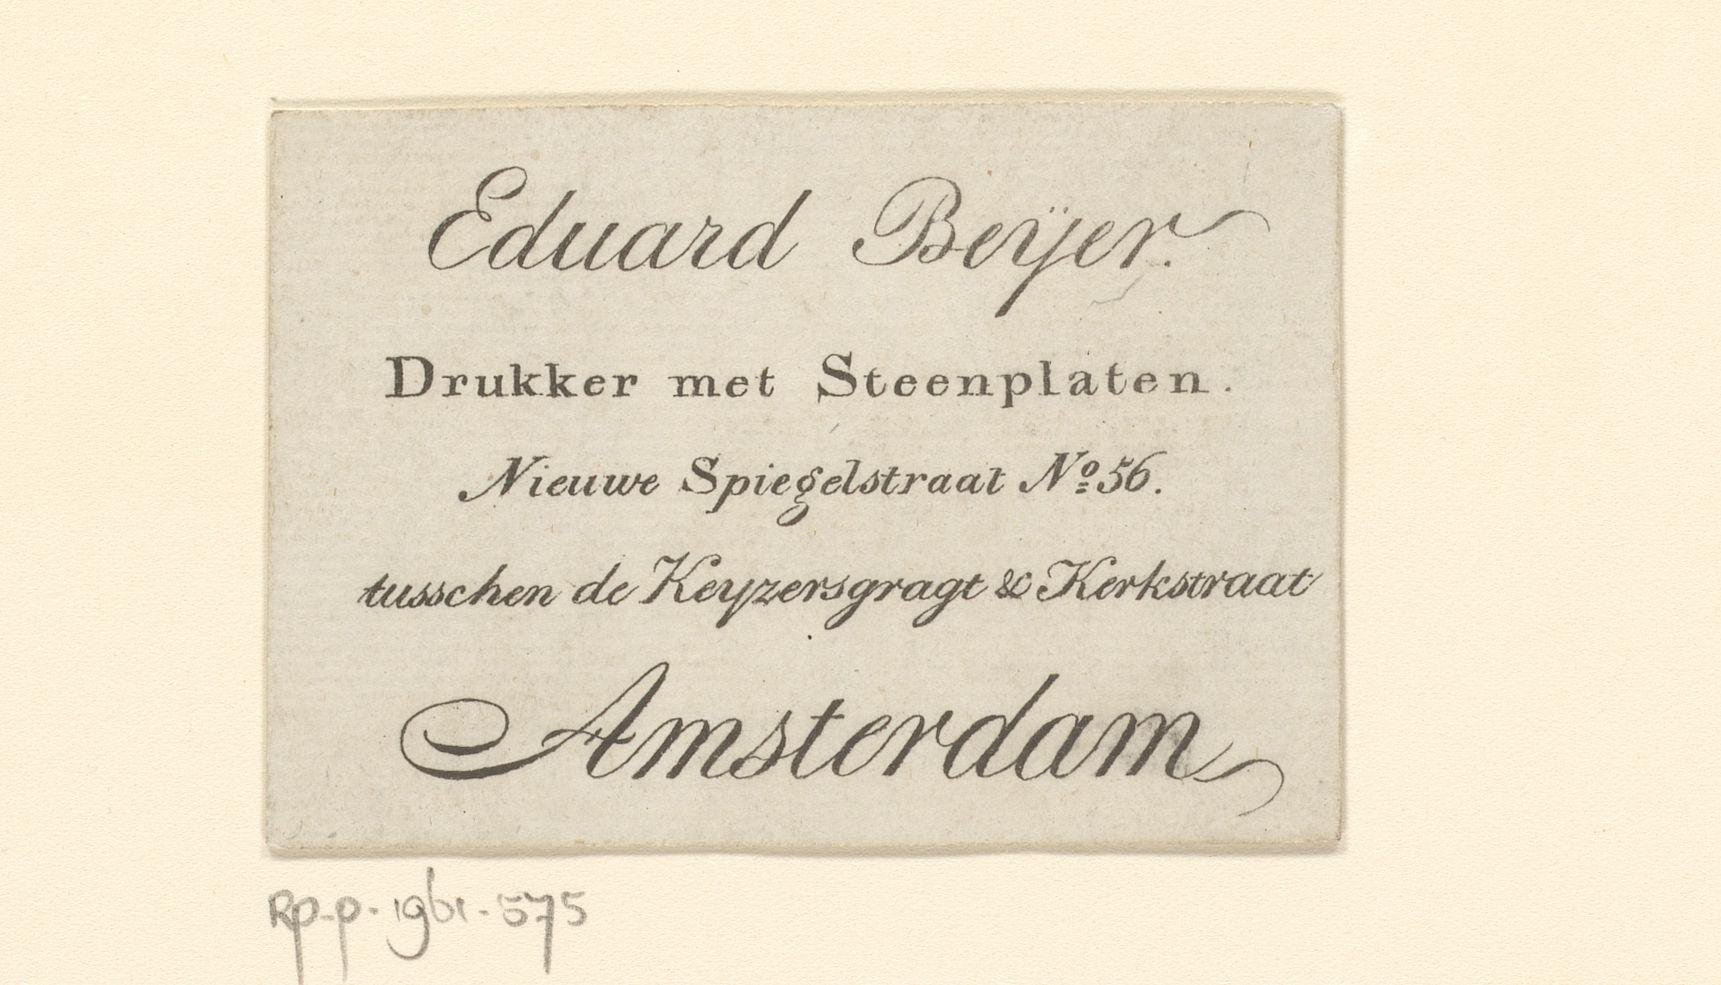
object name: business card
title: Adreskaart van Eduard Beijer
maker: Anonymous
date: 1816-1817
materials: paper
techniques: letterpress printing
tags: eduard beijer, visiting-card, calling-card, amsterdam